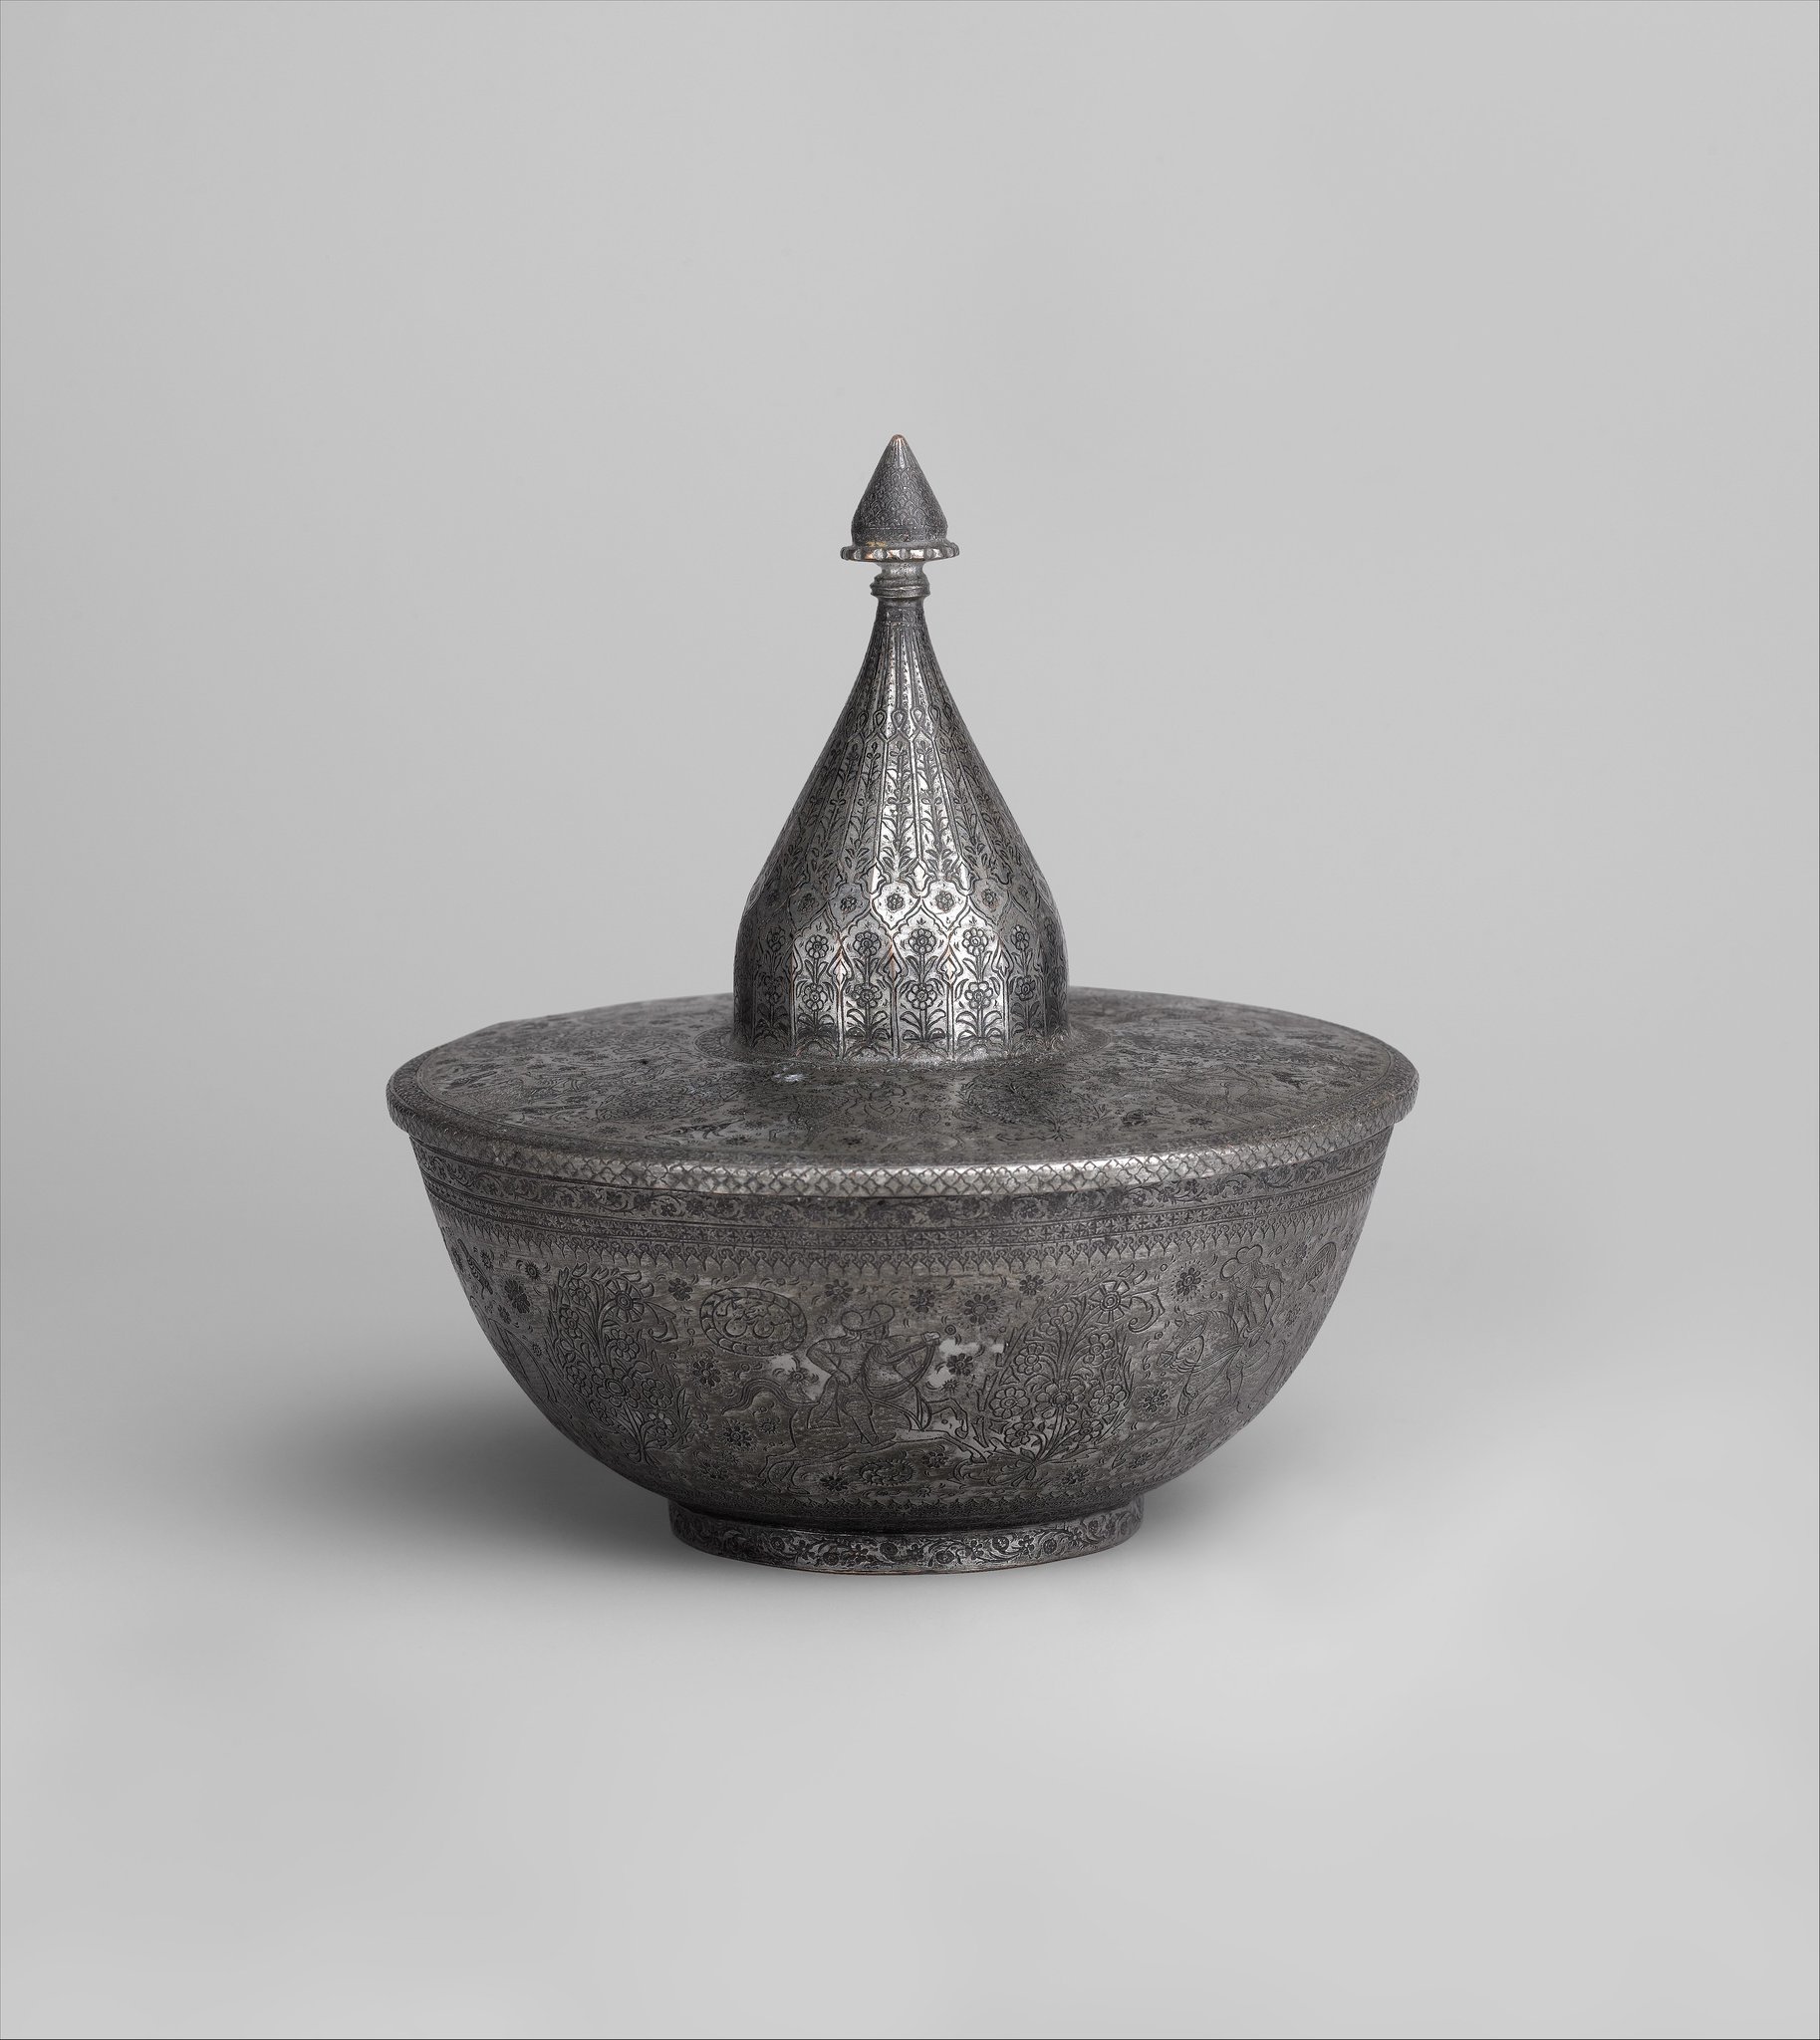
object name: bowl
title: Bowl with Cover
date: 1801-1900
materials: copper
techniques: engraving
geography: iran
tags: men,horses,flowers